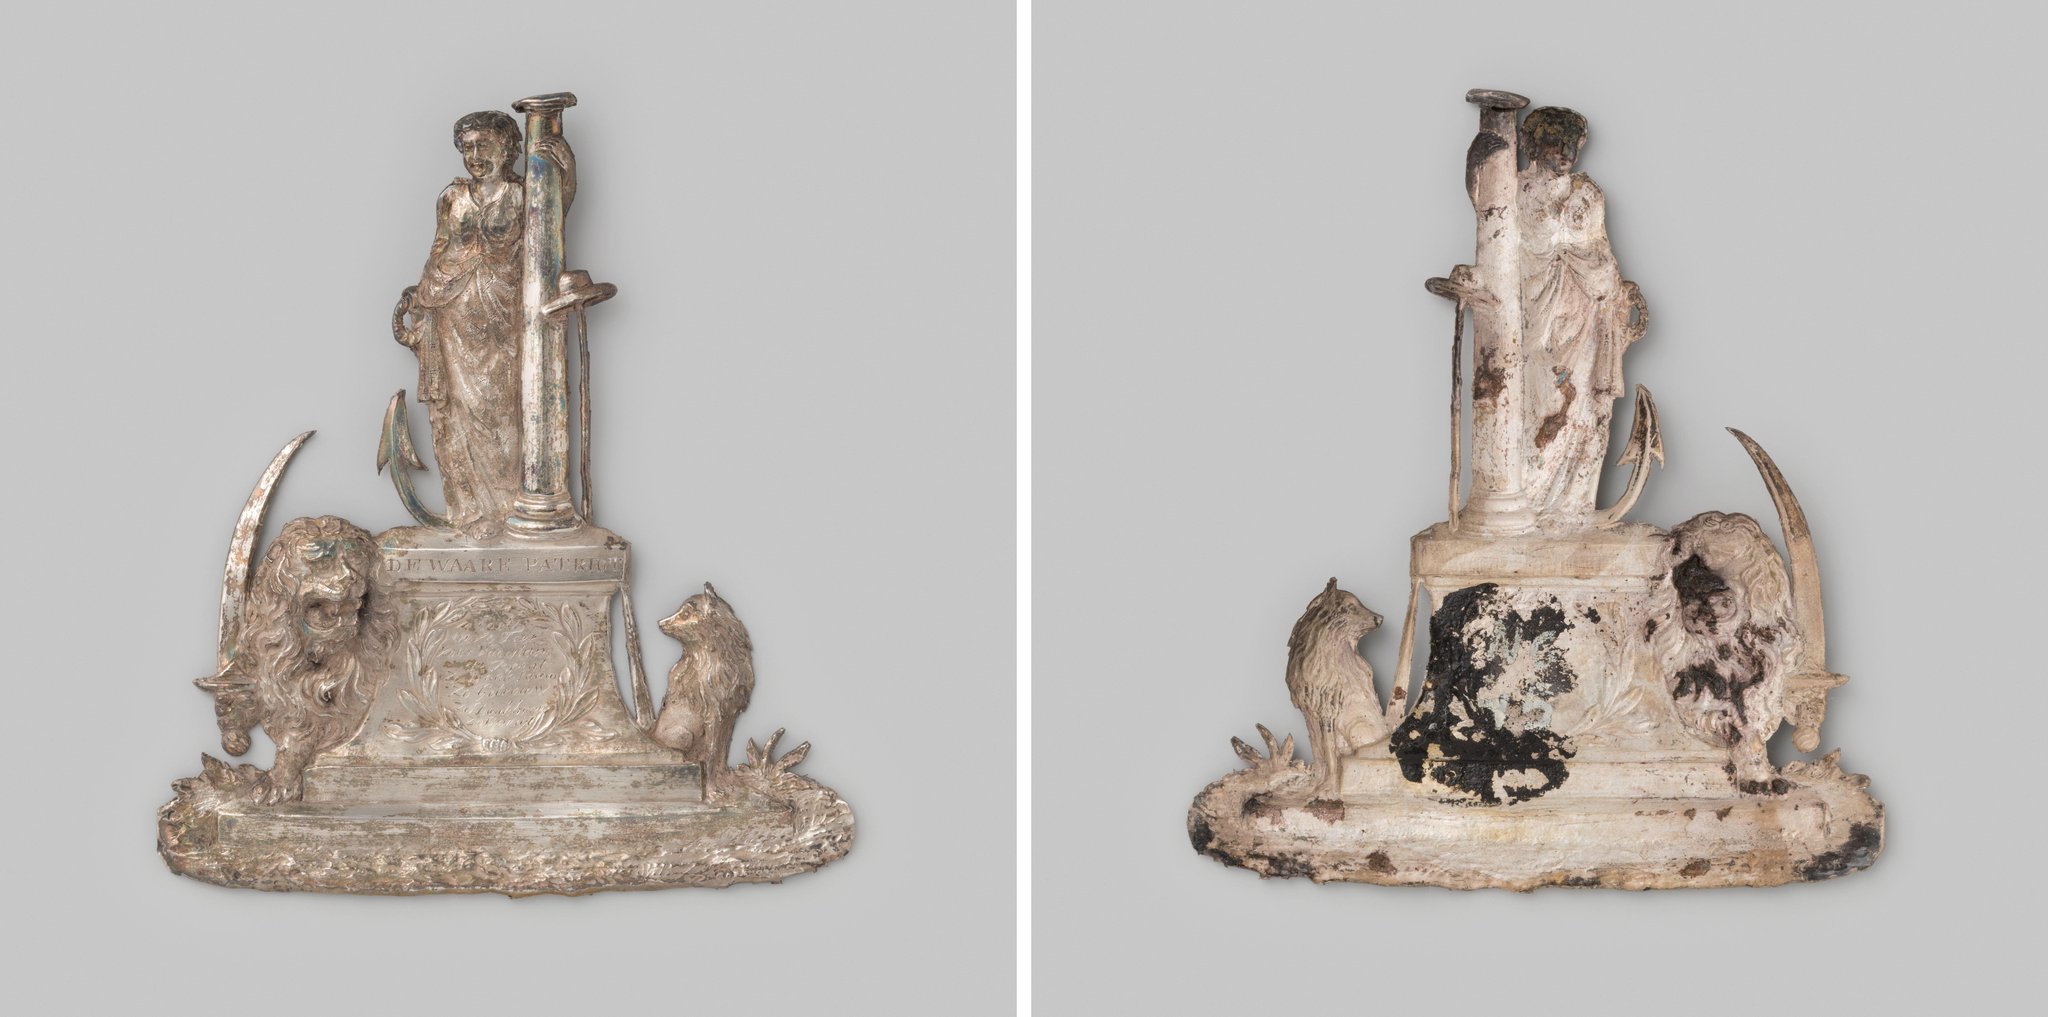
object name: plaque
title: De waare patriot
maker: Anonymous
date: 1784-1787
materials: silver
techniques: embroidery, engraving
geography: netherlands